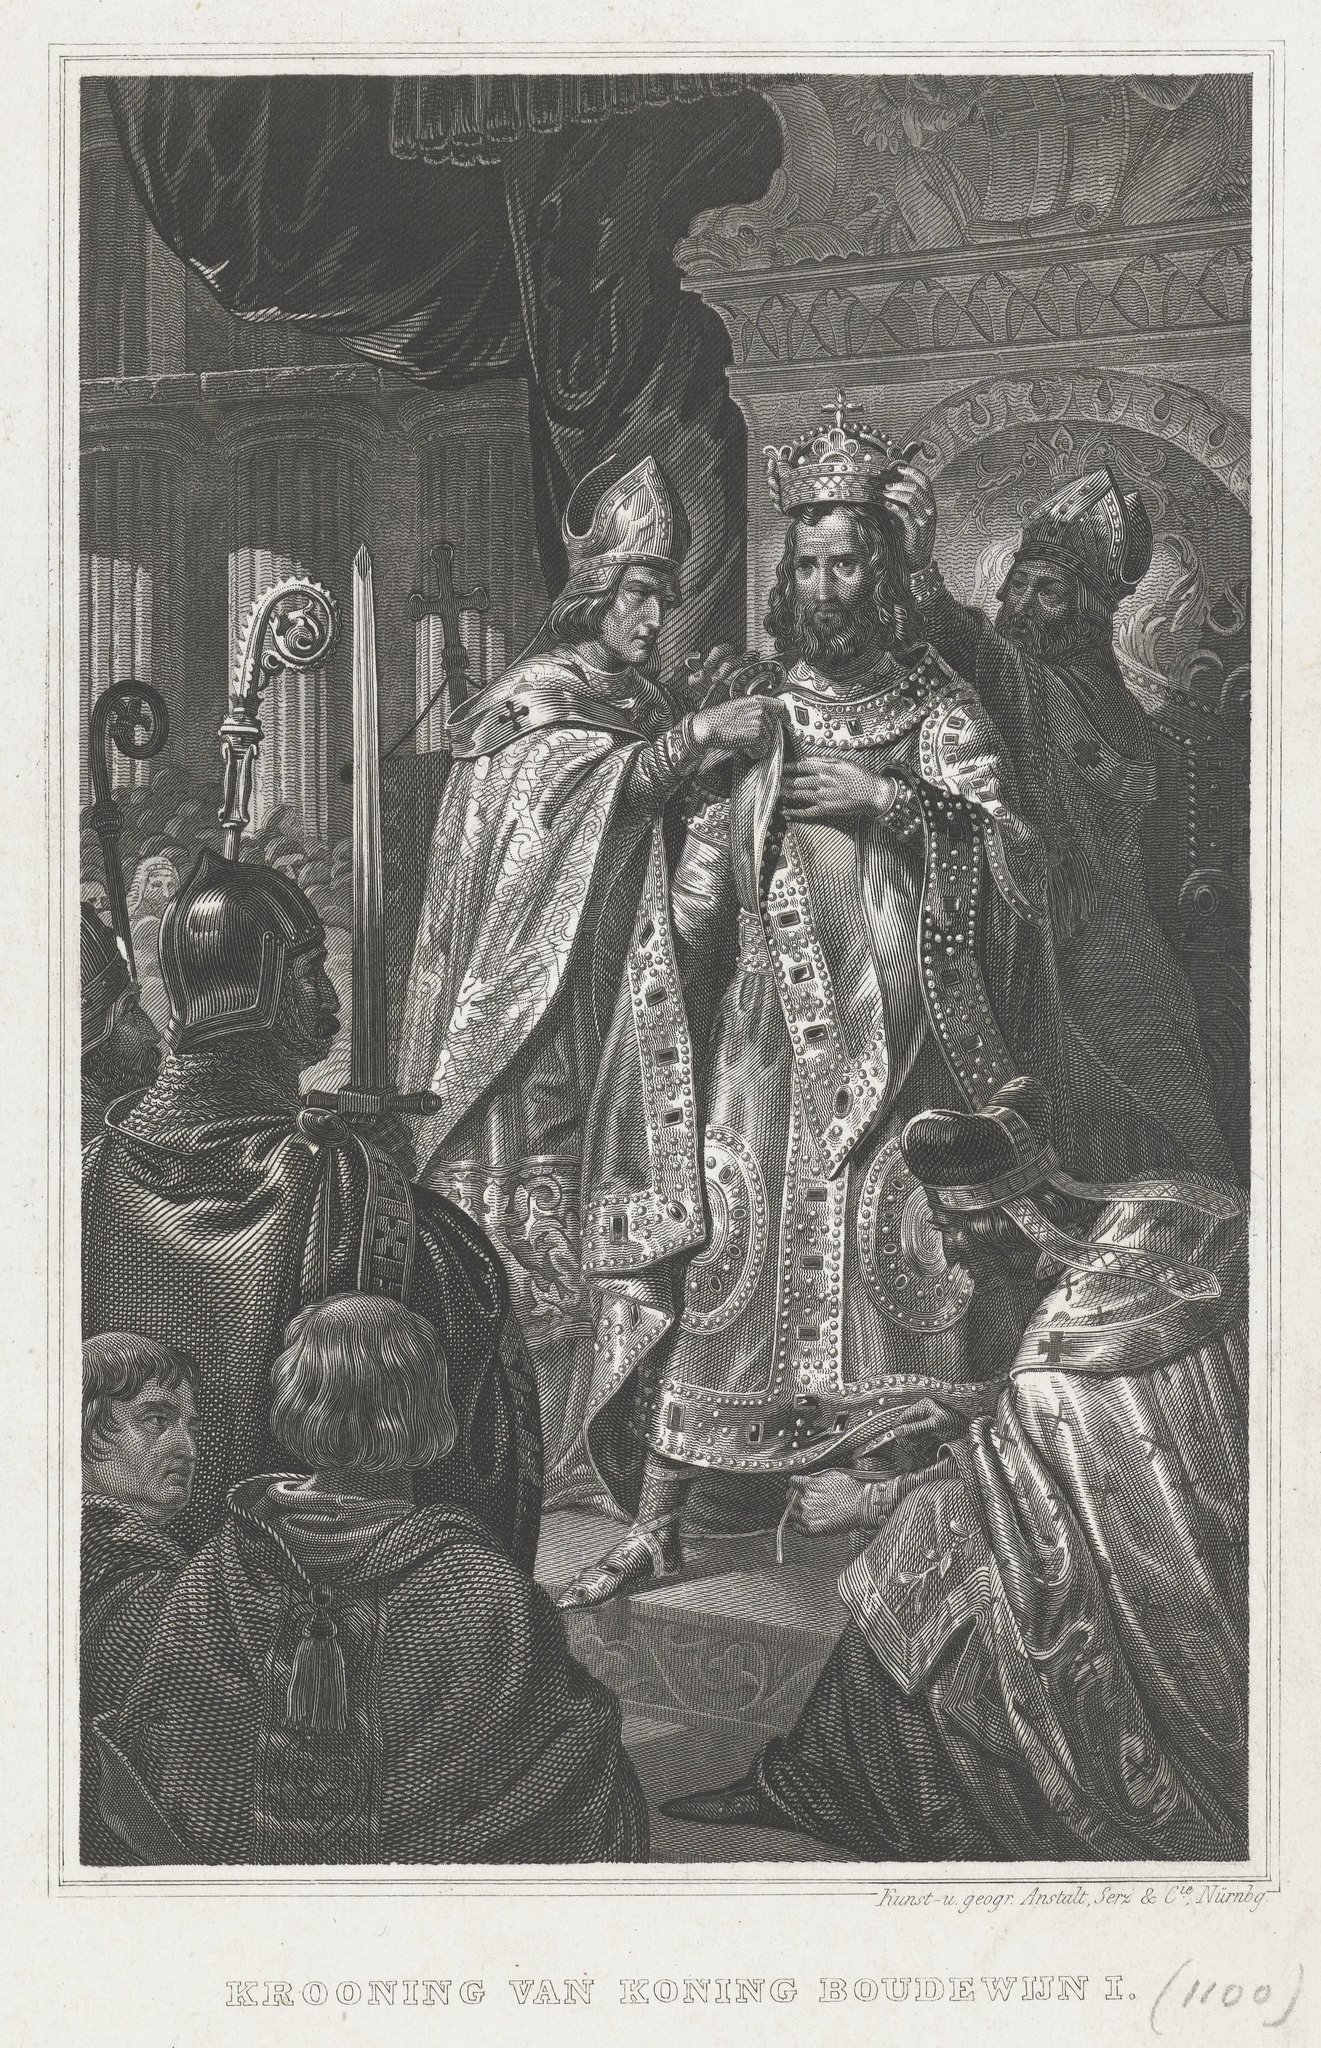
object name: history print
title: Boudewijn I gekroond tot koning van Jeruzalem, 1100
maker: Anonymous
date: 1800-1899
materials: paper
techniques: engraving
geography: nuremberg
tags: during the coronation, netherlands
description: Boudewijn I gekroond tot koning van Jeruzalem op 25 december 1100. Boudewijn nam in 1096 deel aan de Eerste Kruistocht naar het Heilige Land.